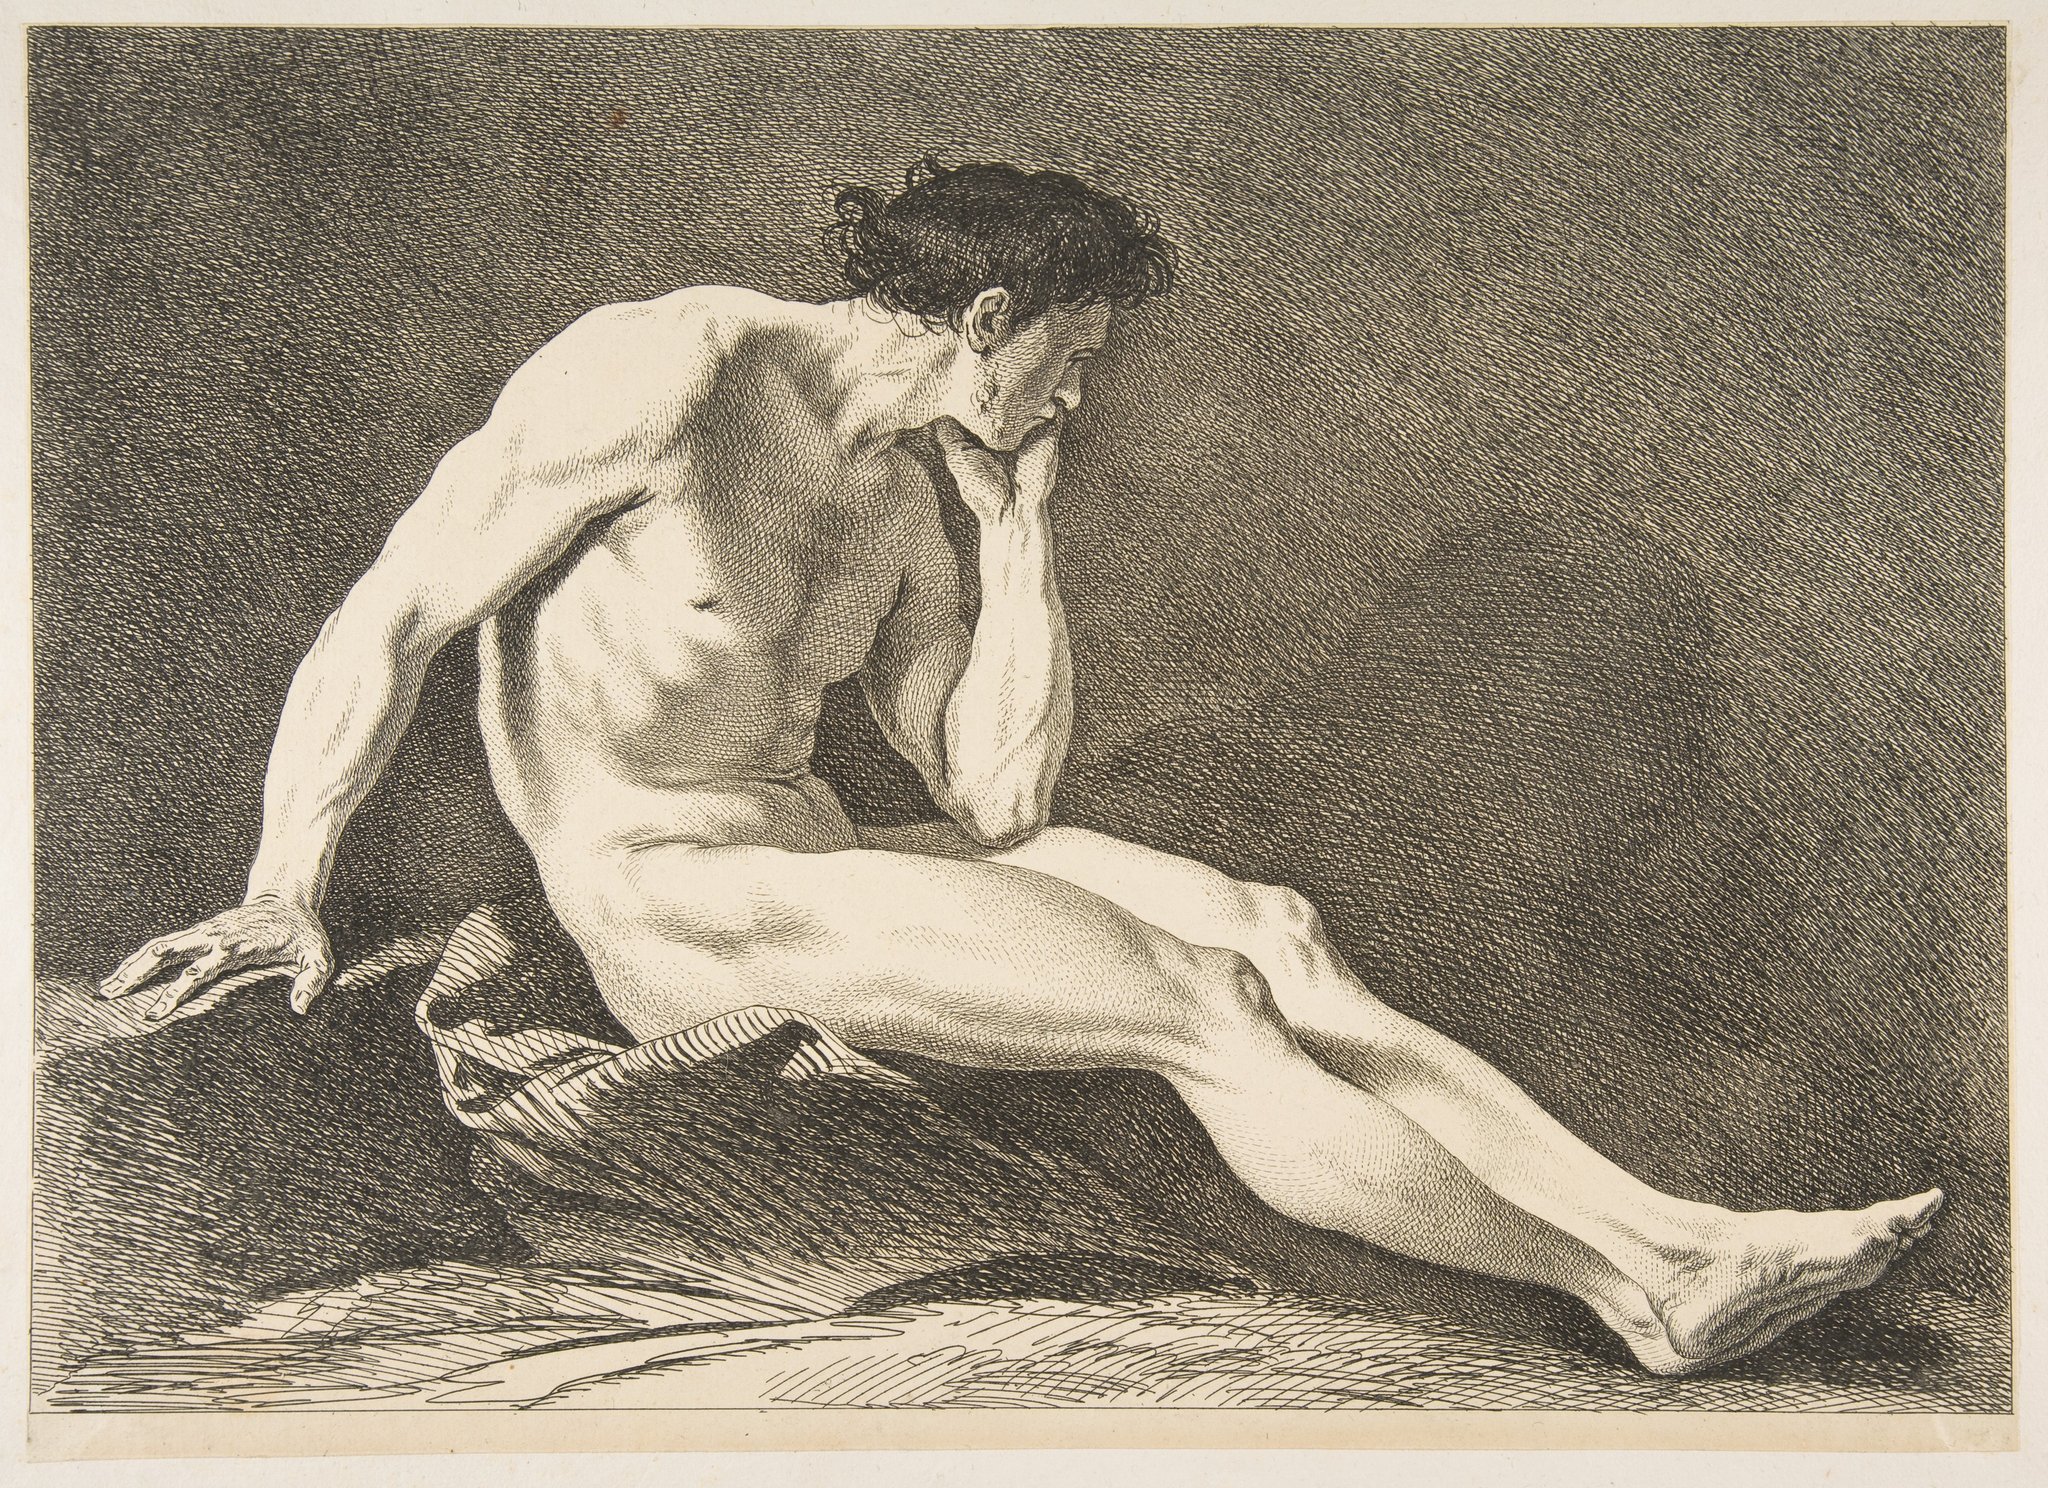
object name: print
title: An "Académie": Sitting Man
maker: carle (charles andré) vanloo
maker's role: artist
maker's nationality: french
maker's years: 1705-1765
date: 1742-1743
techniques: etching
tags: male nudes